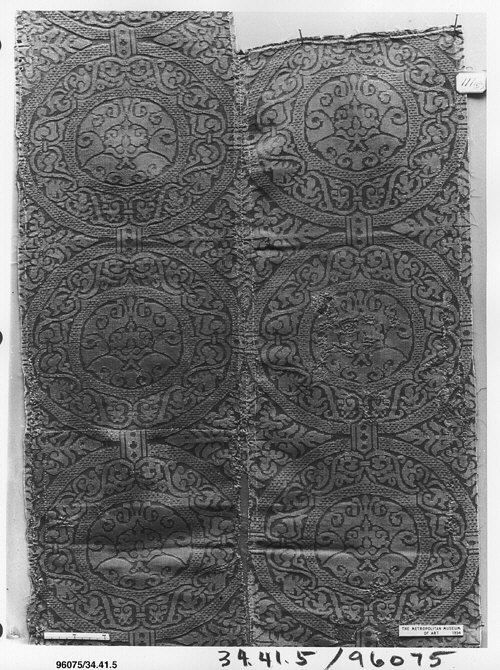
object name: piece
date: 1501-1600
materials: silk